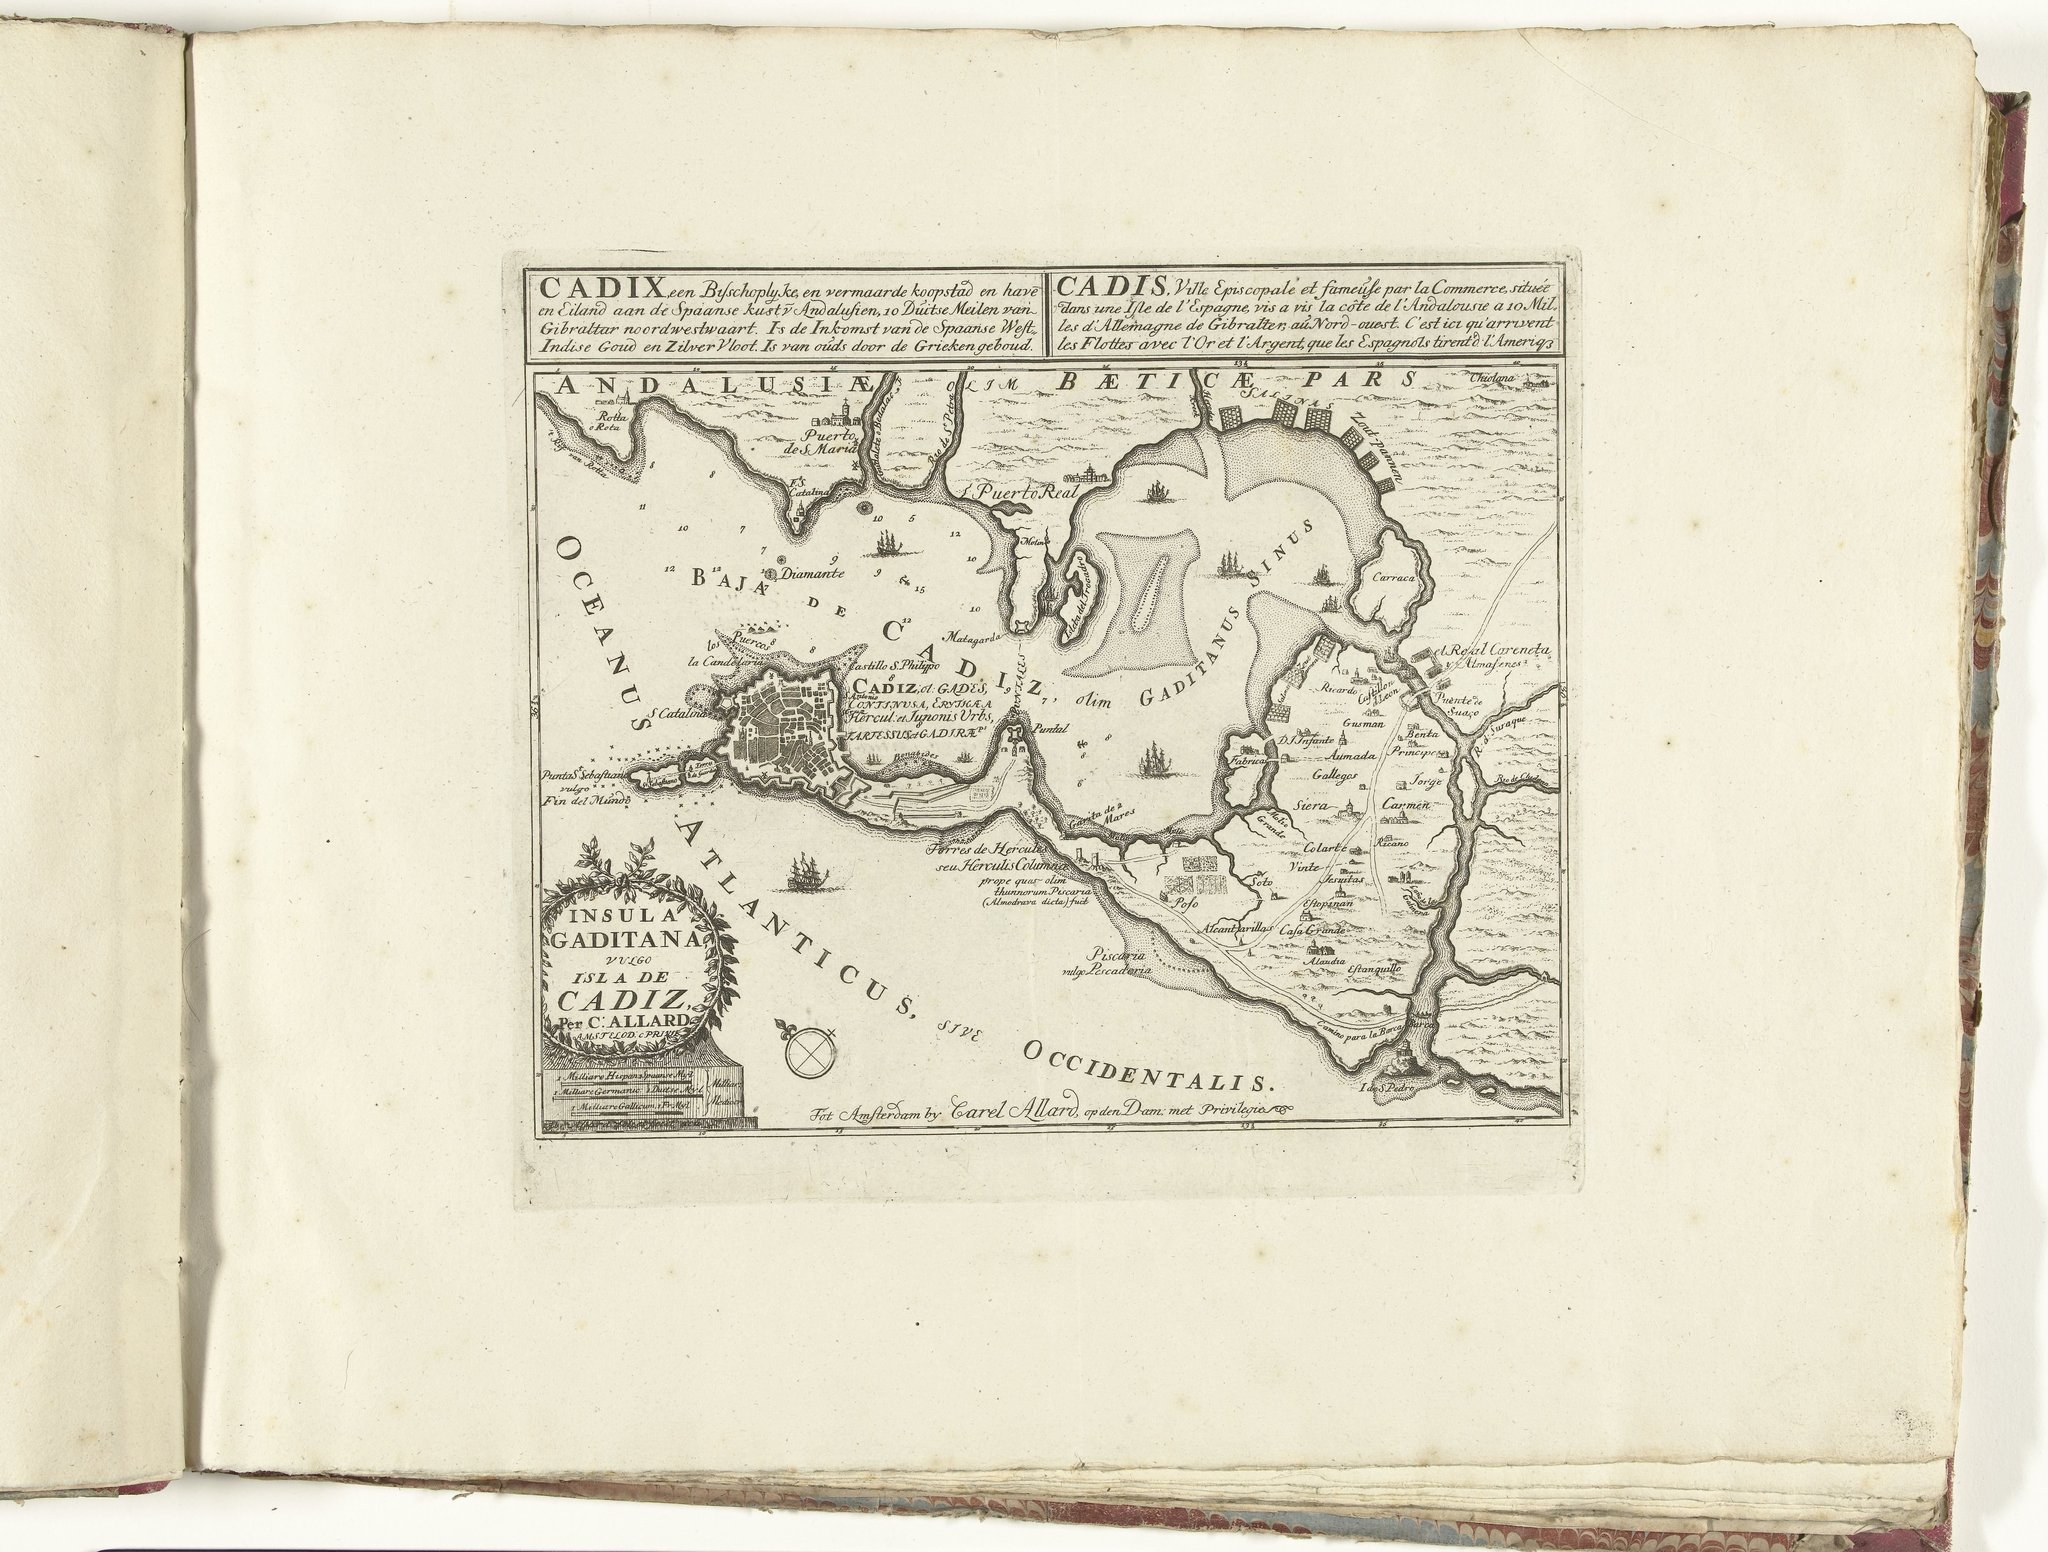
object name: map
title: Kaartje van Cadiz, ca. 1701-1713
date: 1701-1714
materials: paper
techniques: etching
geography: amsterdam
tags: maps of separate countries or regions, maps of cities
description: Gekopieerd naar de Franse prent in: Nicolas de Fer, Les forces de l'Europe, ou description des principales villes, avec leurs fortifications : dessignées par les meilleurs ingenieurs, particulierement celles ... de la France, dont les plans ont esté levez par M. de Vauban, Nicolas de Fer, Parijs 1693-1696, of andere voorbeelden.